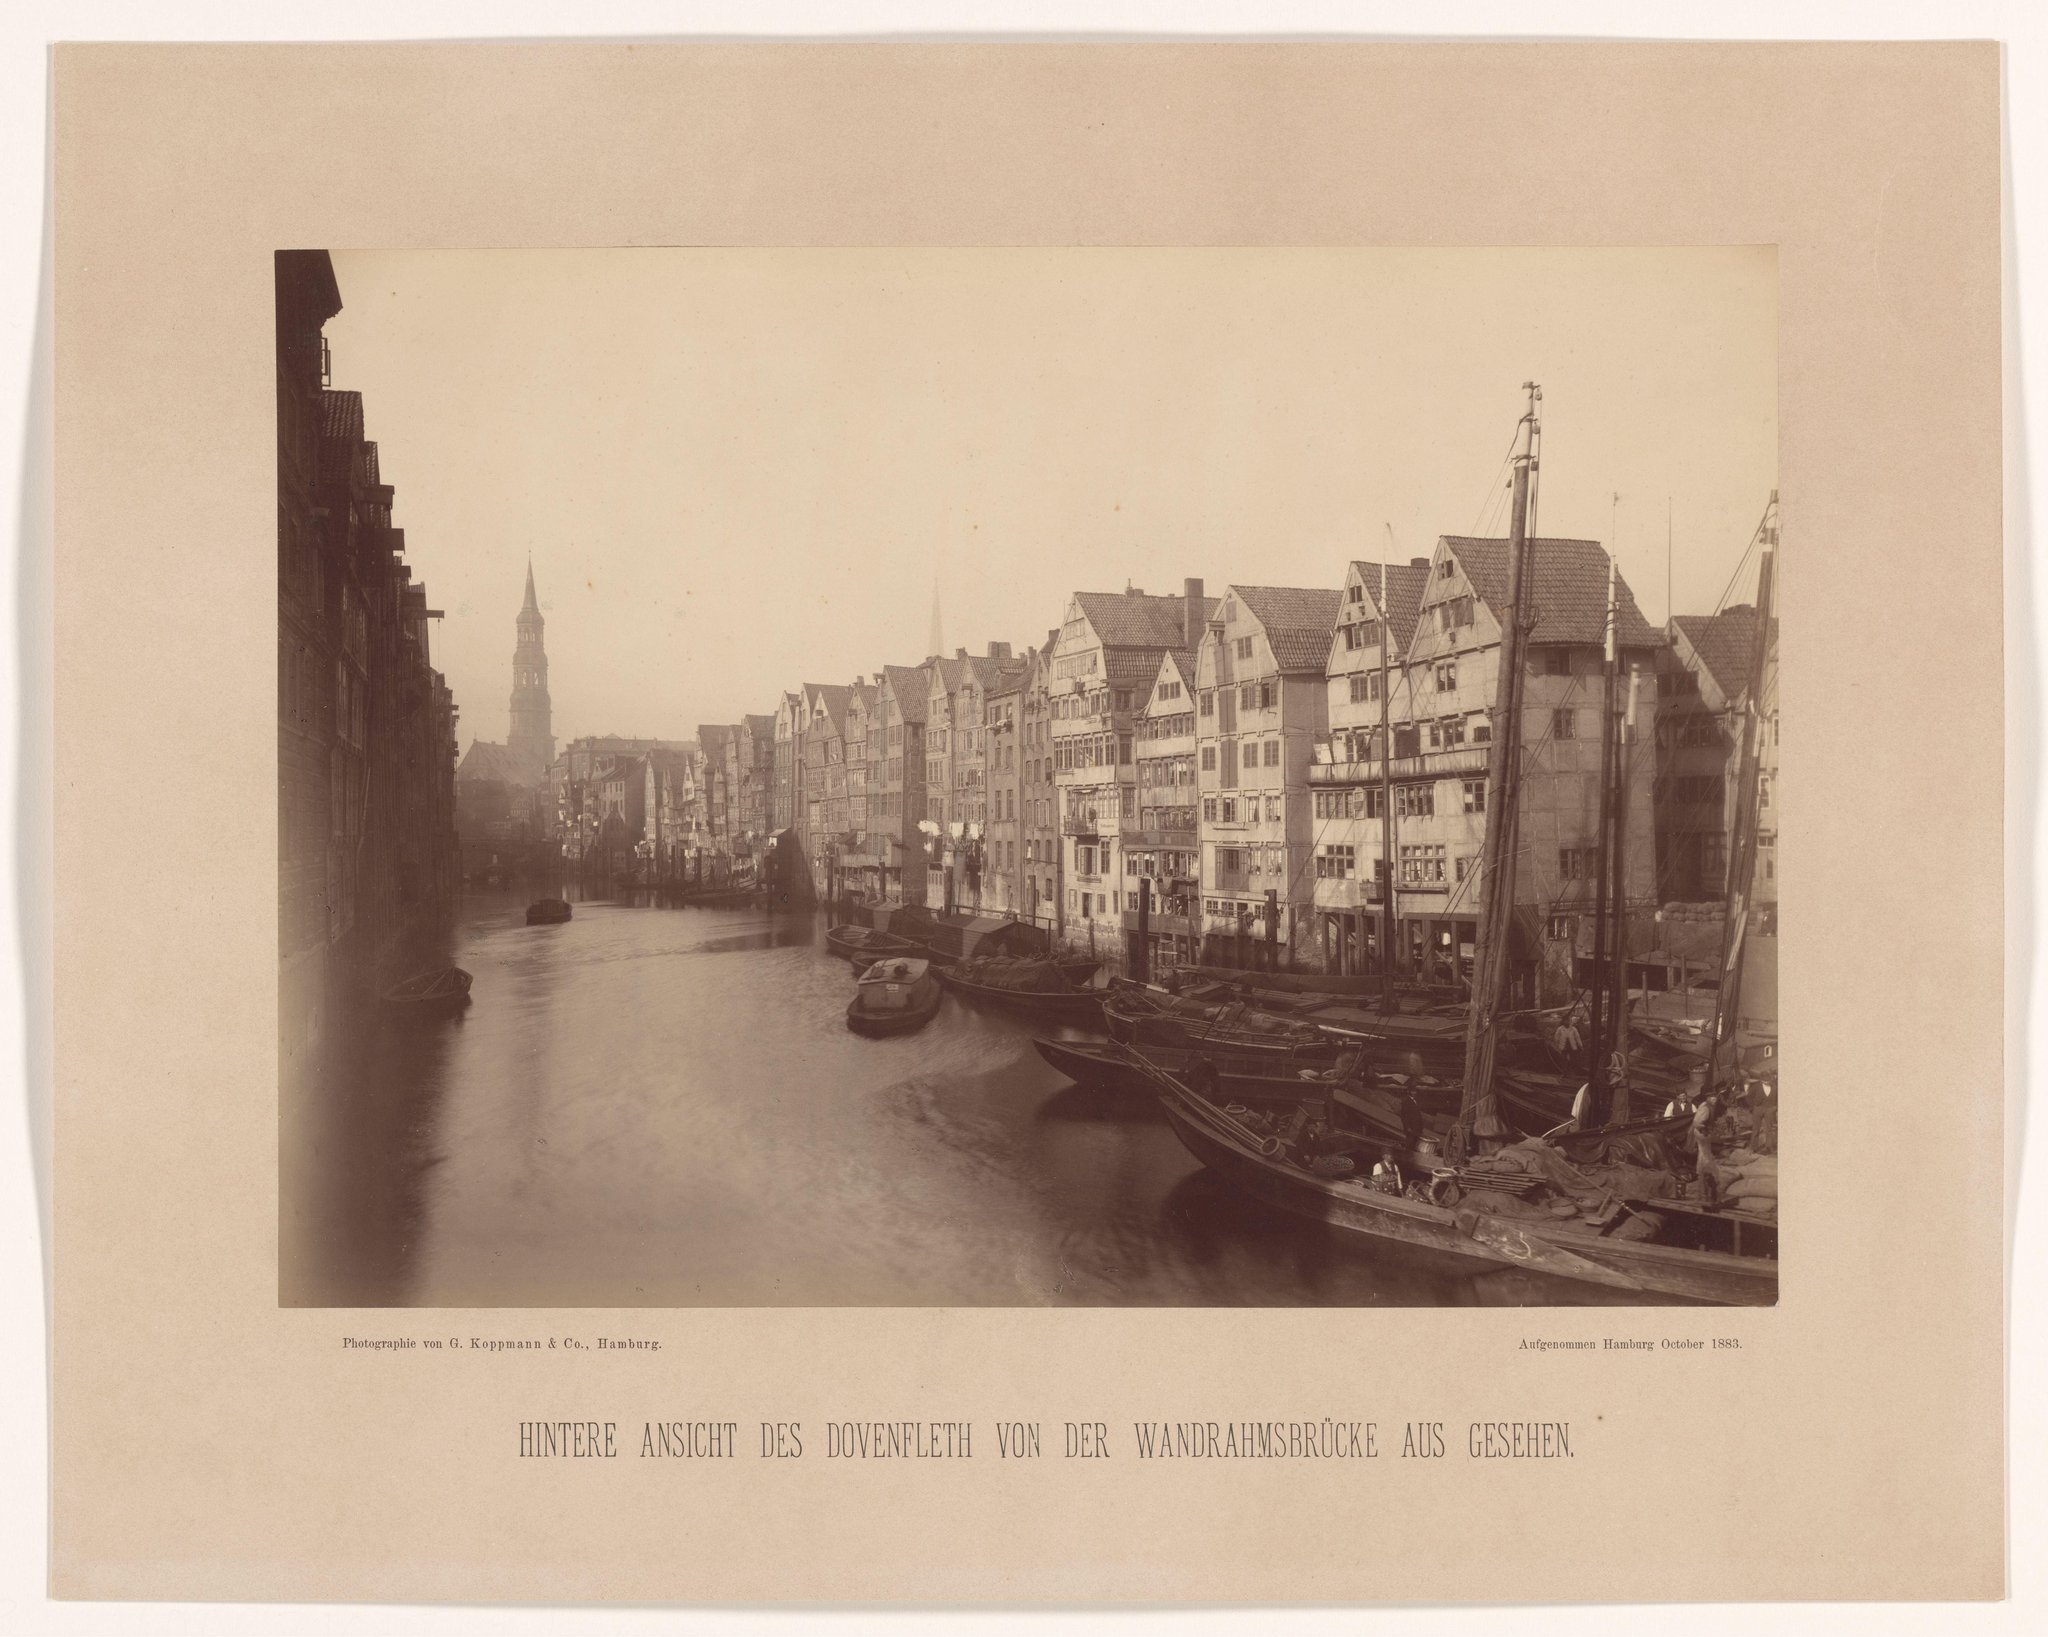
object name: photograph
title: Gezicht op Dovenfleth, Hamburg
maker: georg koppmann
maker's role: fotograaf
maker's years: 1842-1909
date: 1810-1883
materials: cardboard, paper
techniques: albumen print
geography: hamburg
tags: harbour, urban housing, canal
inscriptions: date: ‘Aufgenommen Hamburg October 1883.’, number: ‘27157/1a’, signature: ‘Photographie von G. Koppmann & Co., Hamburg.’